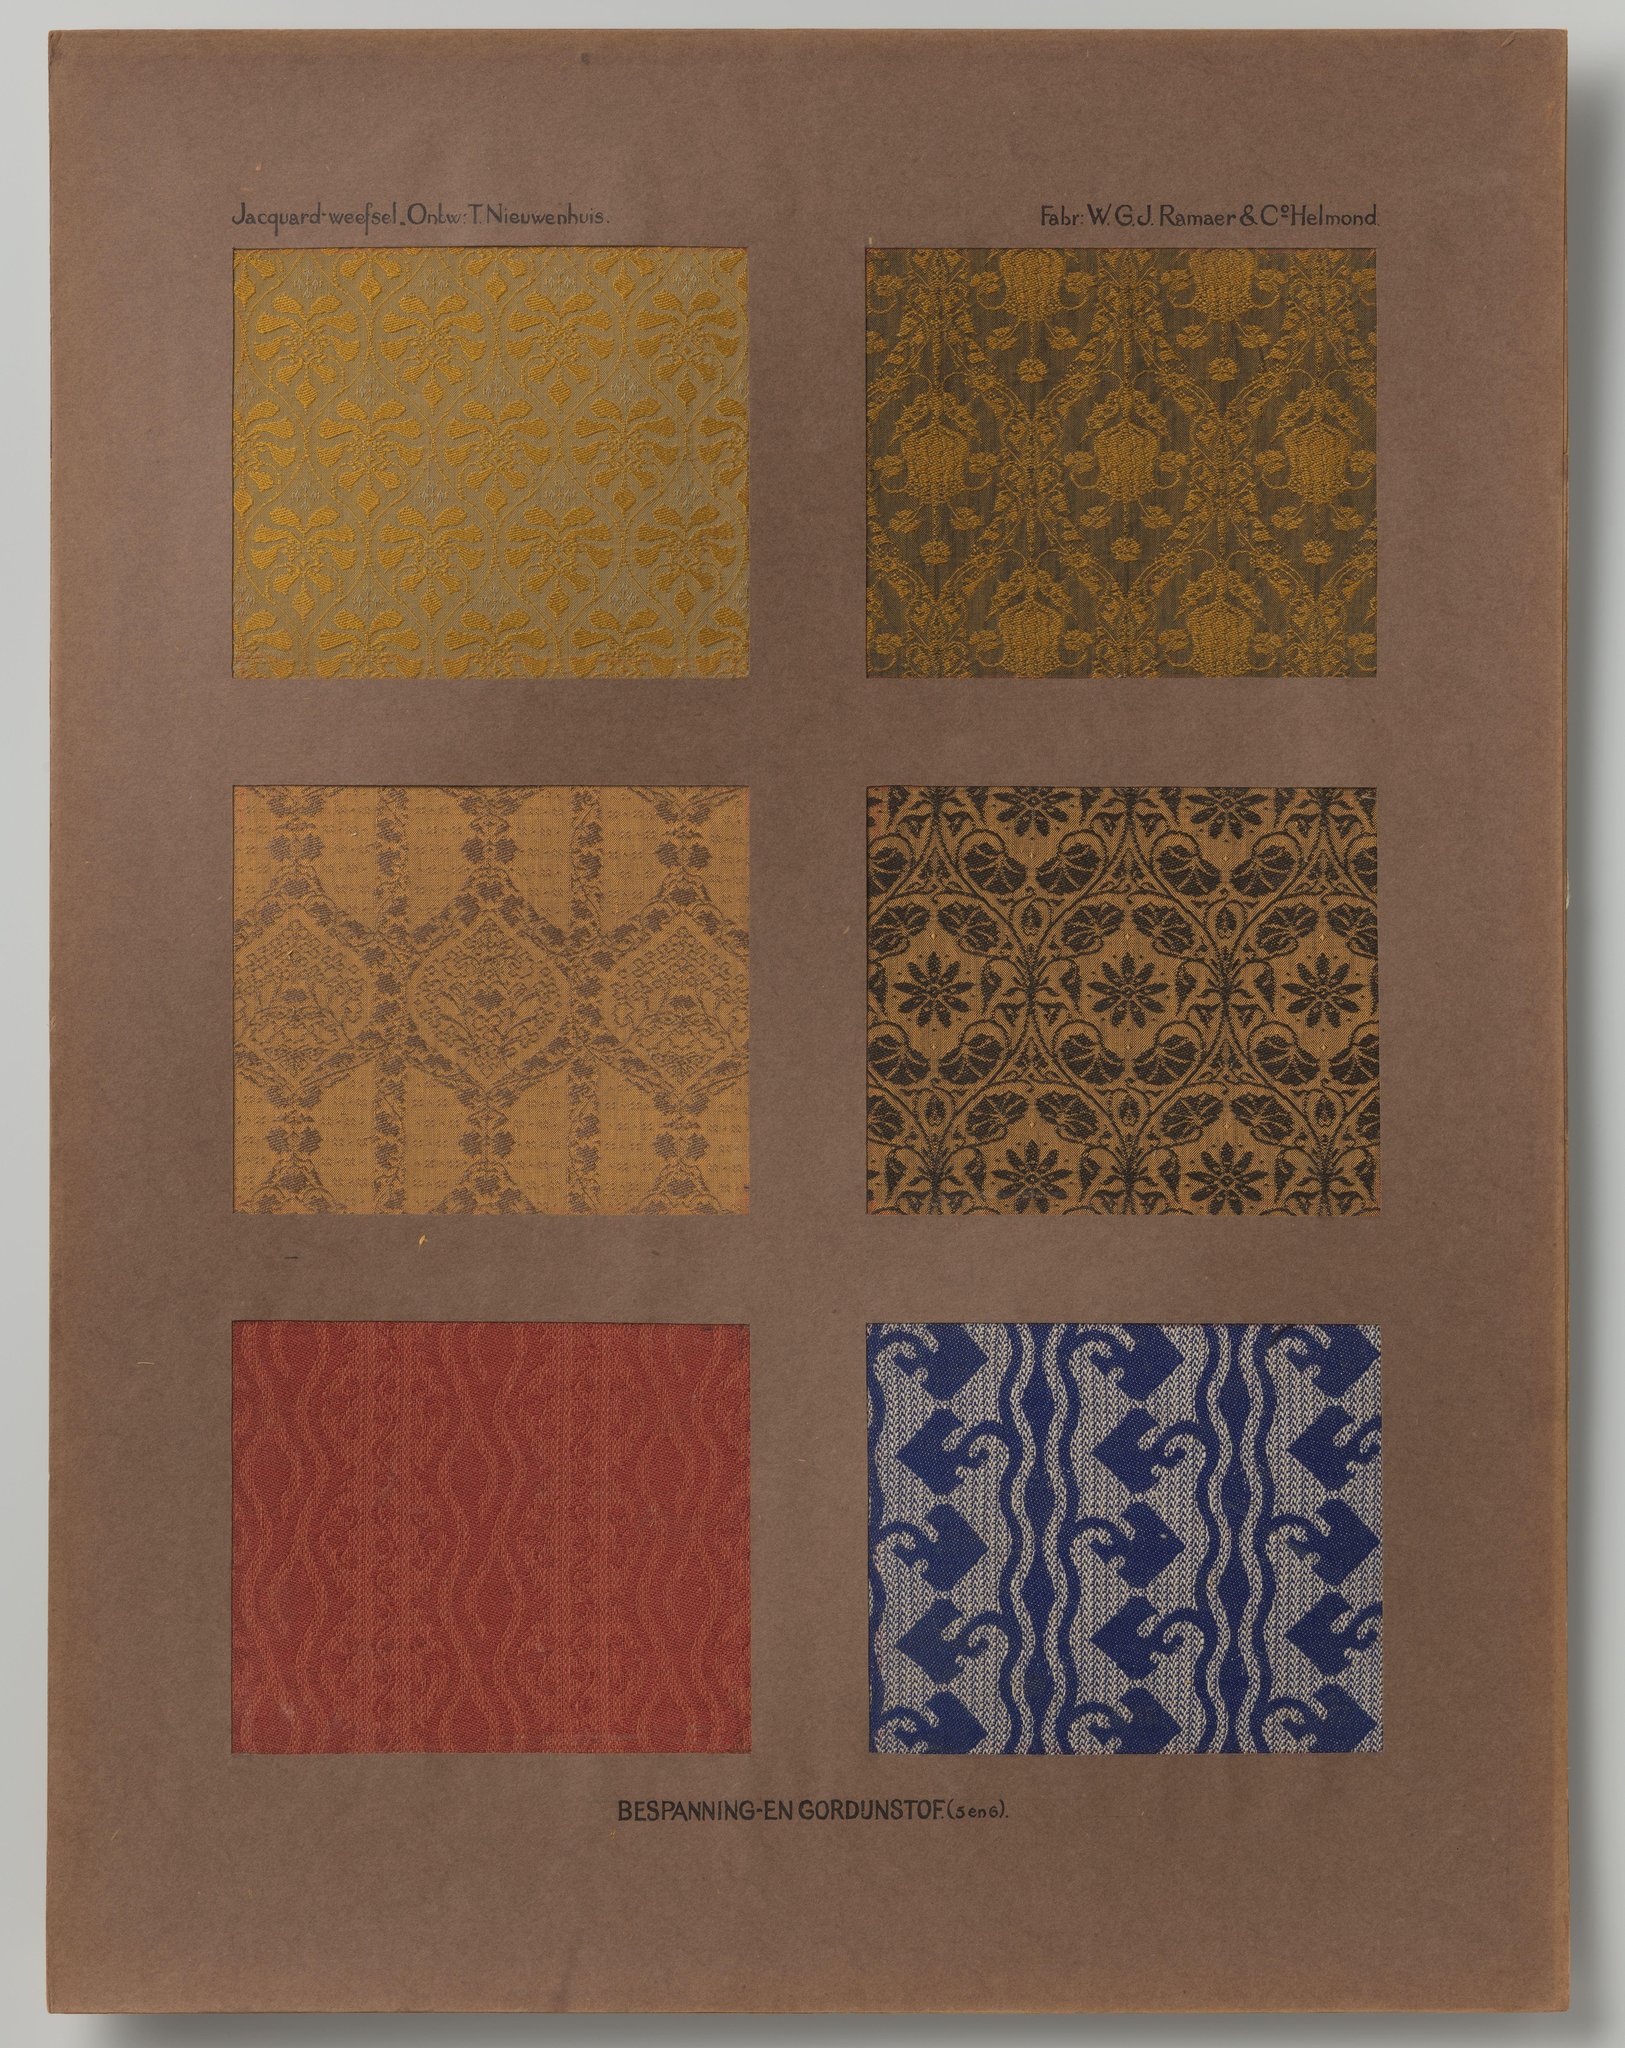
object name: gordijnstof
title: Stalen bespanning- en gordijnstof naar ontwerp van Theo Nieuwenhuis in passe-partout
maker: theo nieuwenhuis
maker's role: designer, draughtsman, print maker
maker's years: 1866-1951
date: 1910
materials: cardboard, cotton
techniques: jacquard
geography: netherlands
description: Zes stalen bespanning- en gordijnstof met florale patronen van jacquardgeweven katoen naar ontwerp van Theo Nieuwenhuis. In origineel passe-partout.